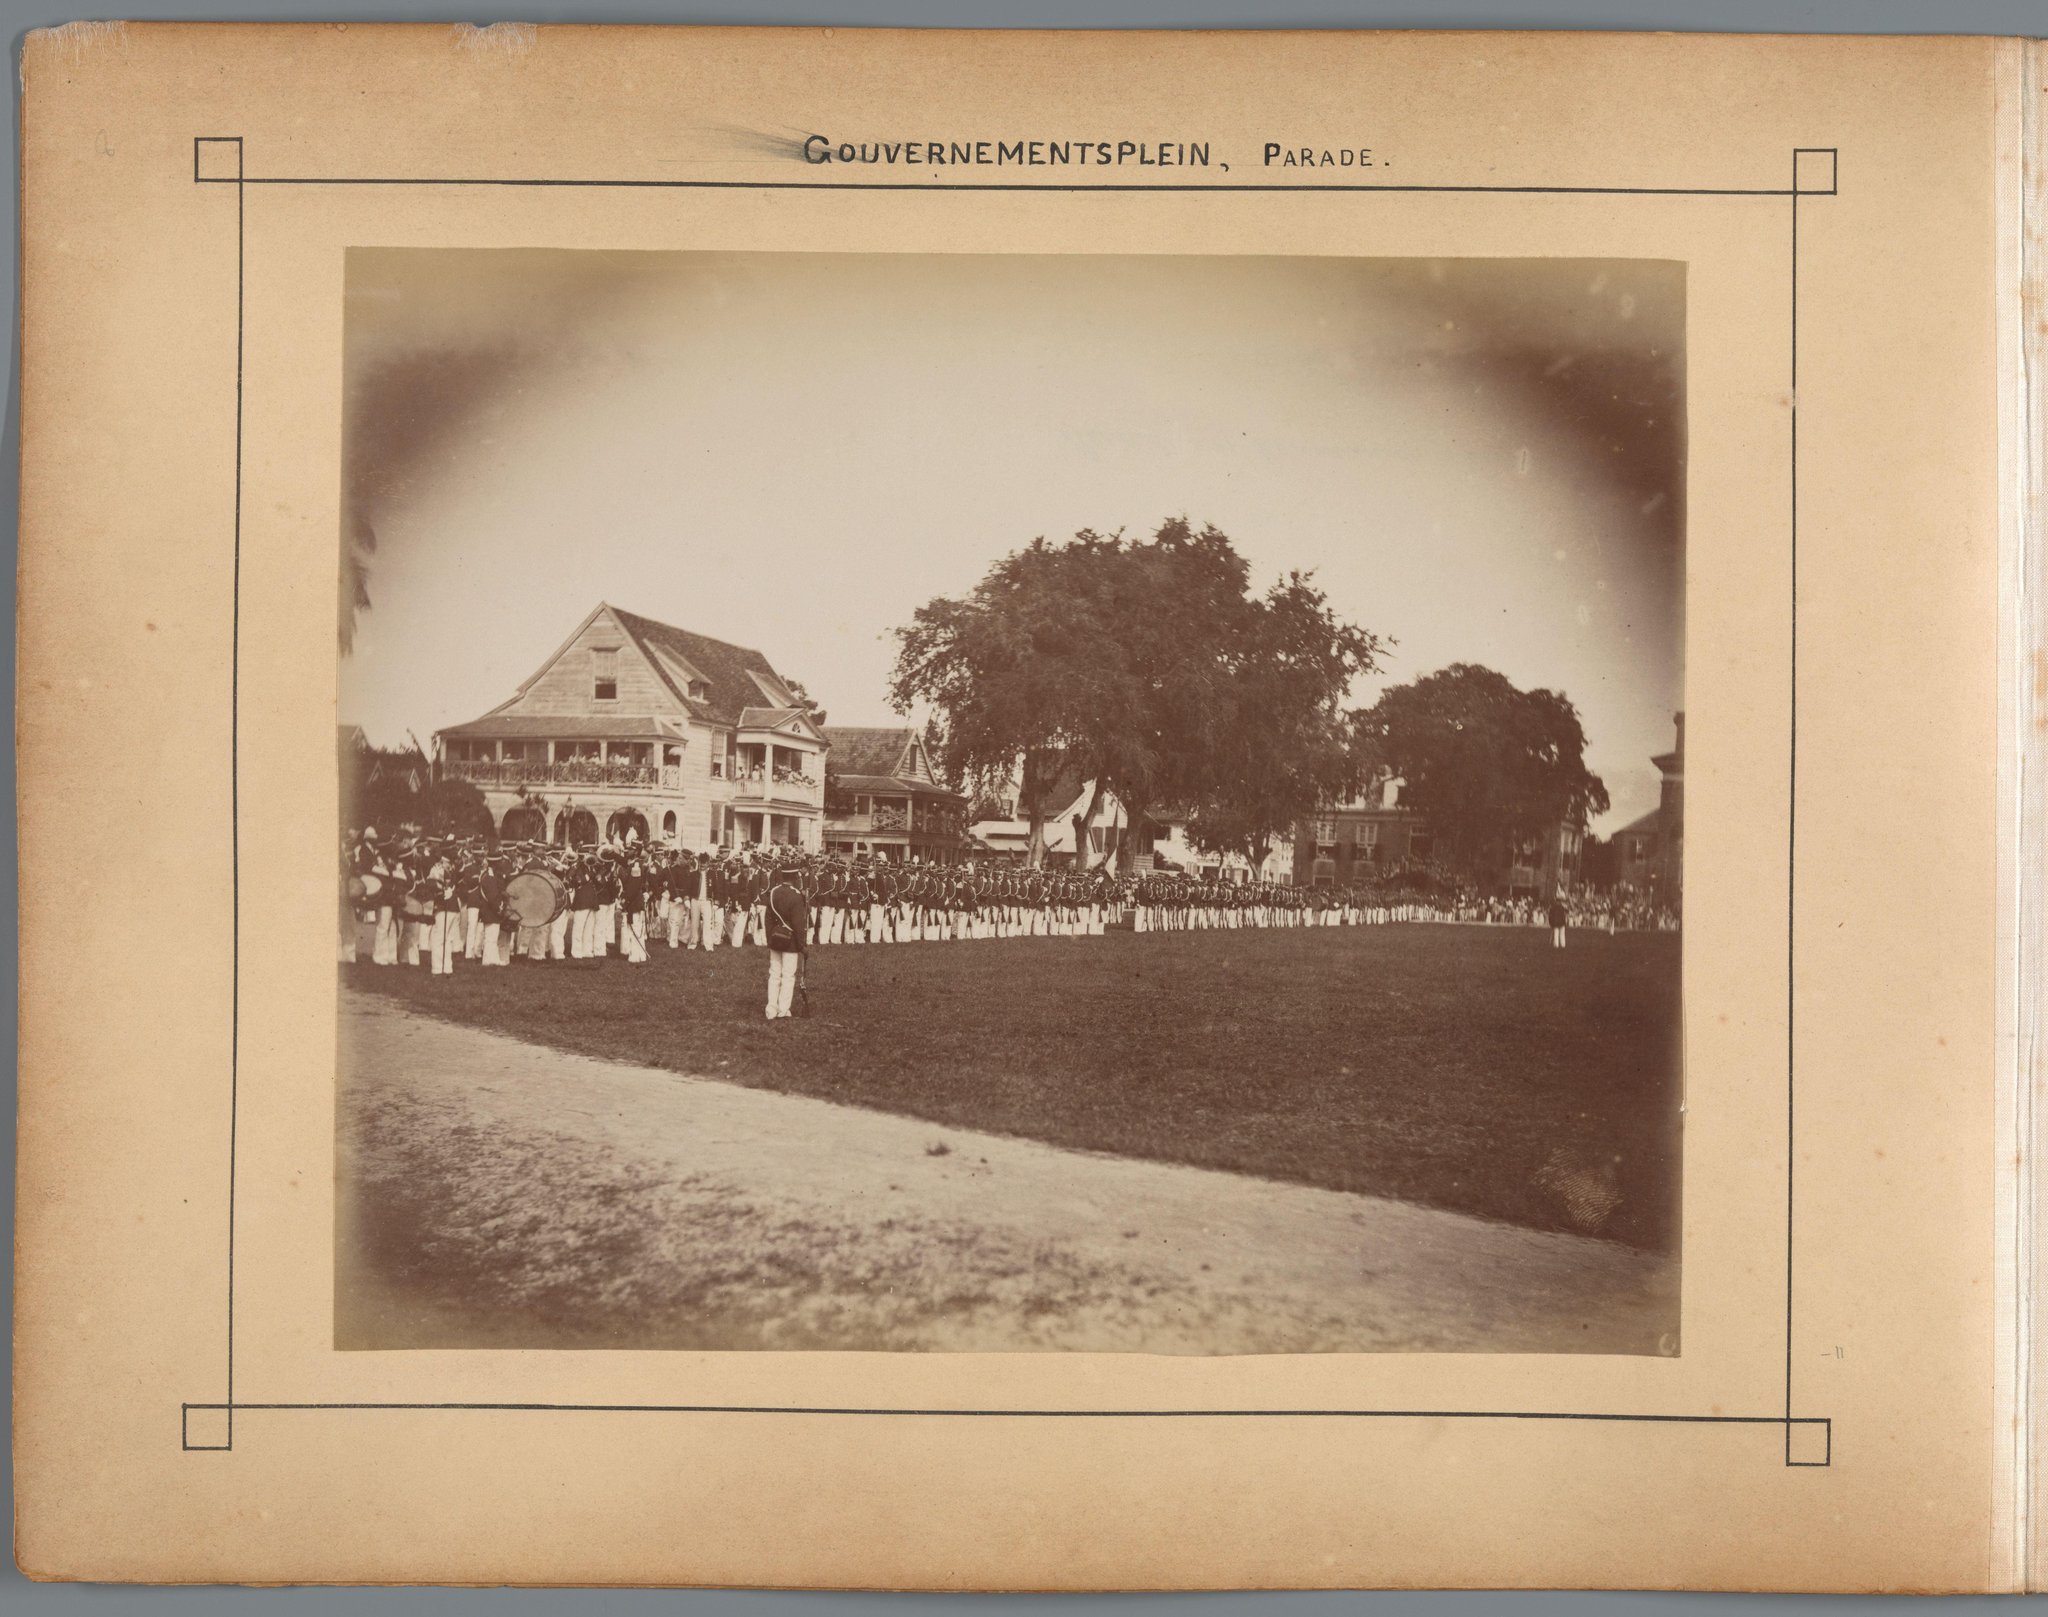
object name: photograph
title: Gouvernementsplein, Parade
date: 1898-1902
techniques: albumen print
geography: suriname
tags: suriname